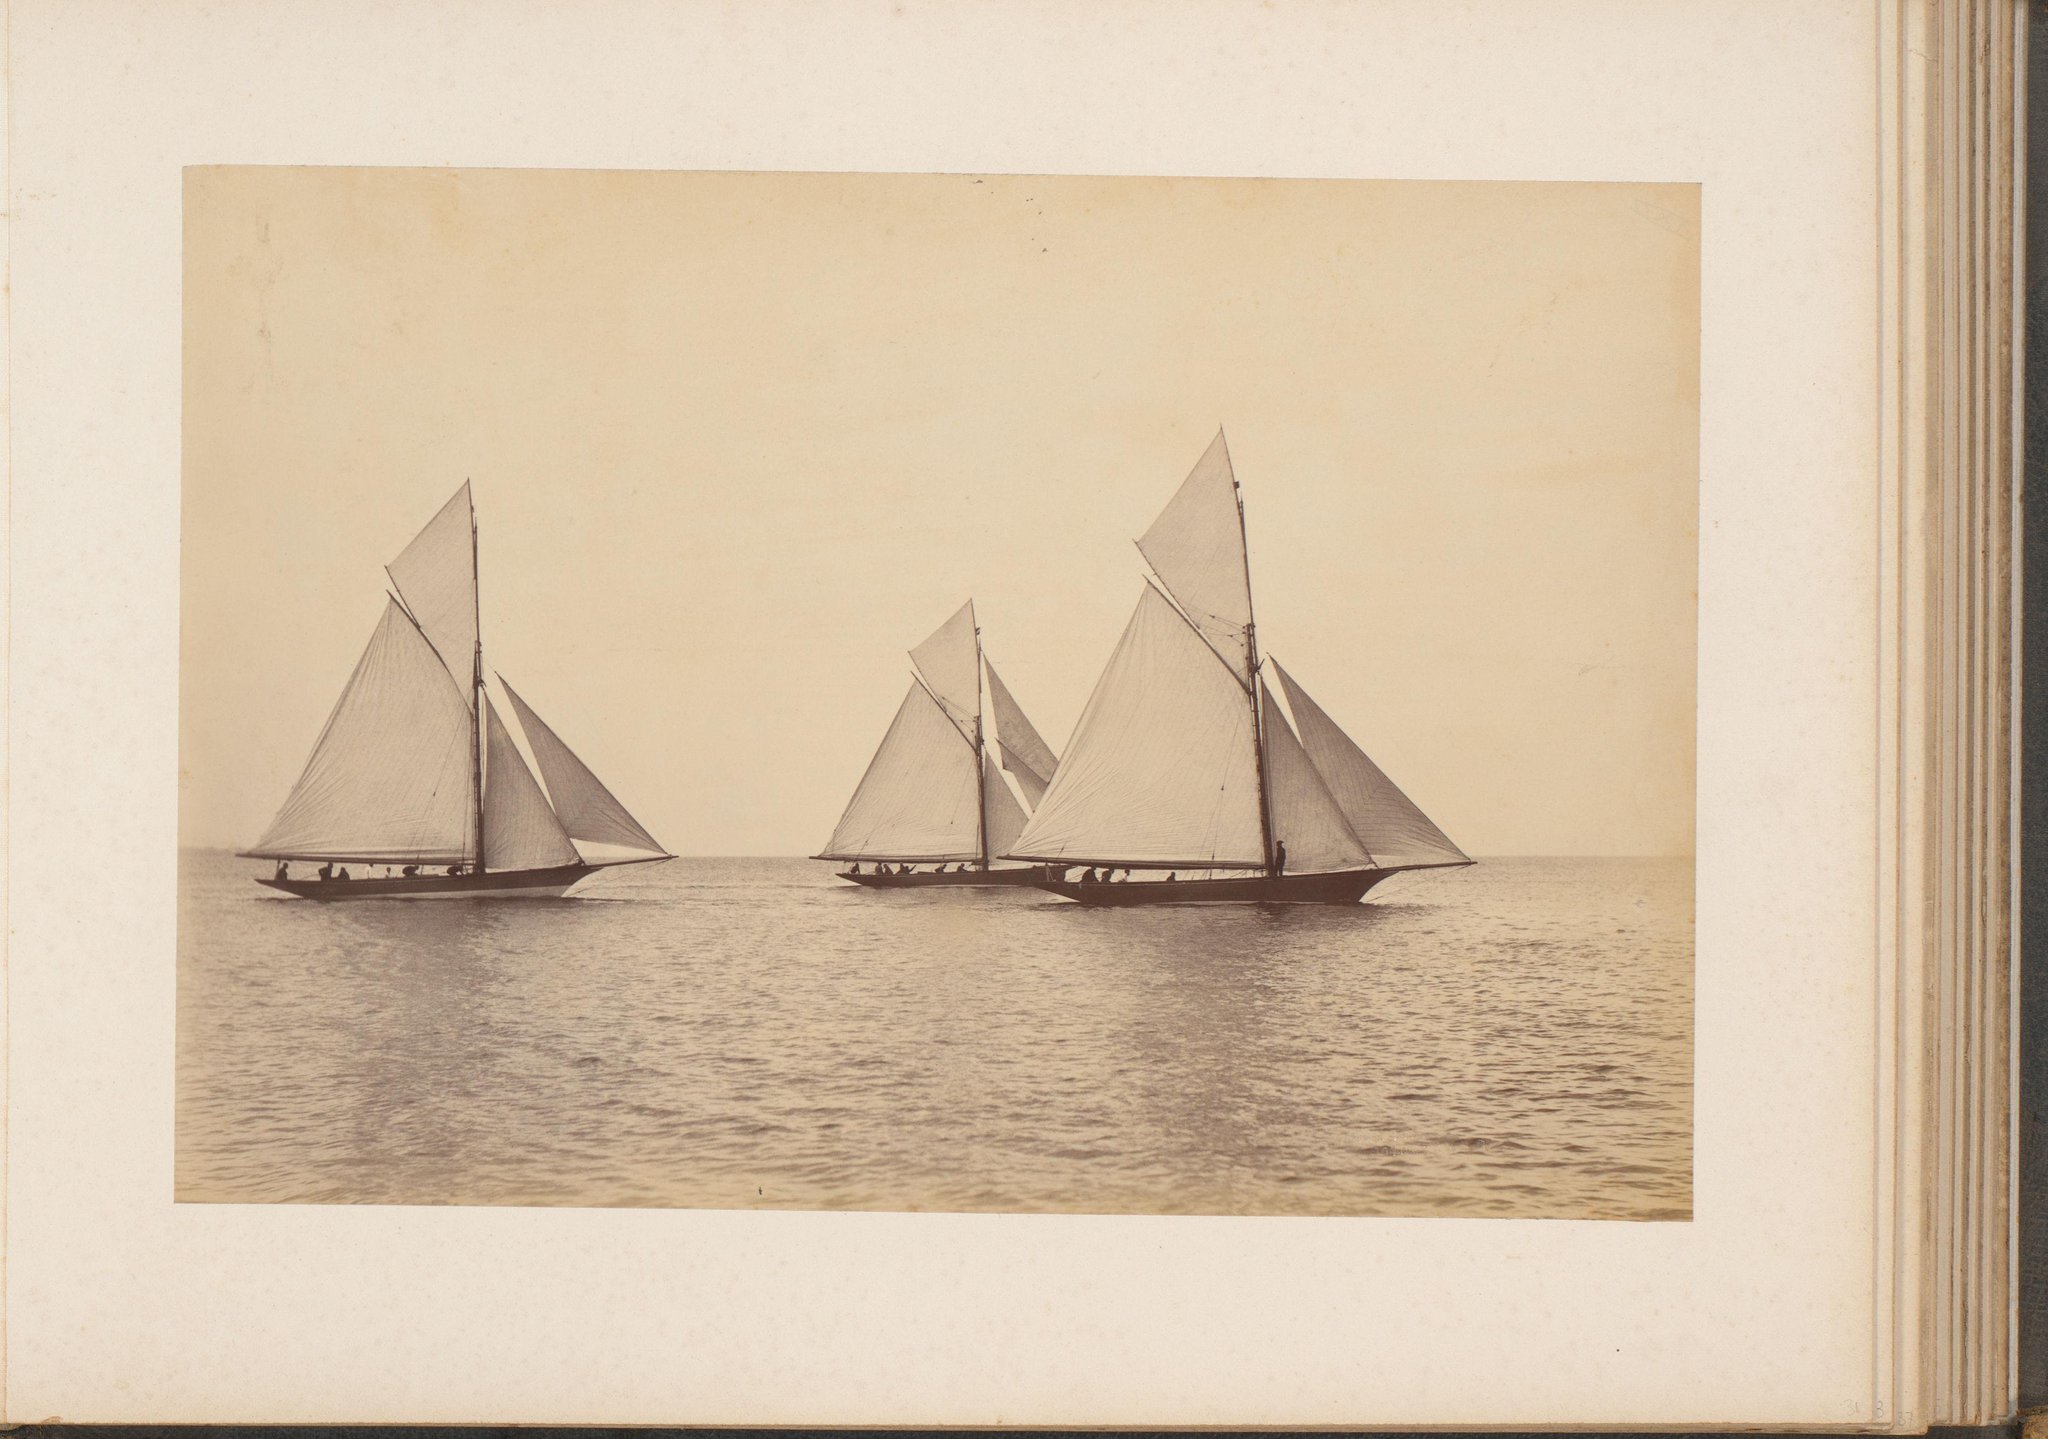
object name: album leaf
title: Drie zeilschepen, waaronder de Encore, Yvonne en Woodcock, te water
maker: james adamson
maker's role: fotograaf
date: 1880-1900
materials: photographic support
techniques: albumen print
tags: sailing-ship, sailing-boat, landscapes with waters, waterscapes, seascapes (in the temperate zone)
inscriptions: check stamp: ‘Adamson, Rothesay.H.B’